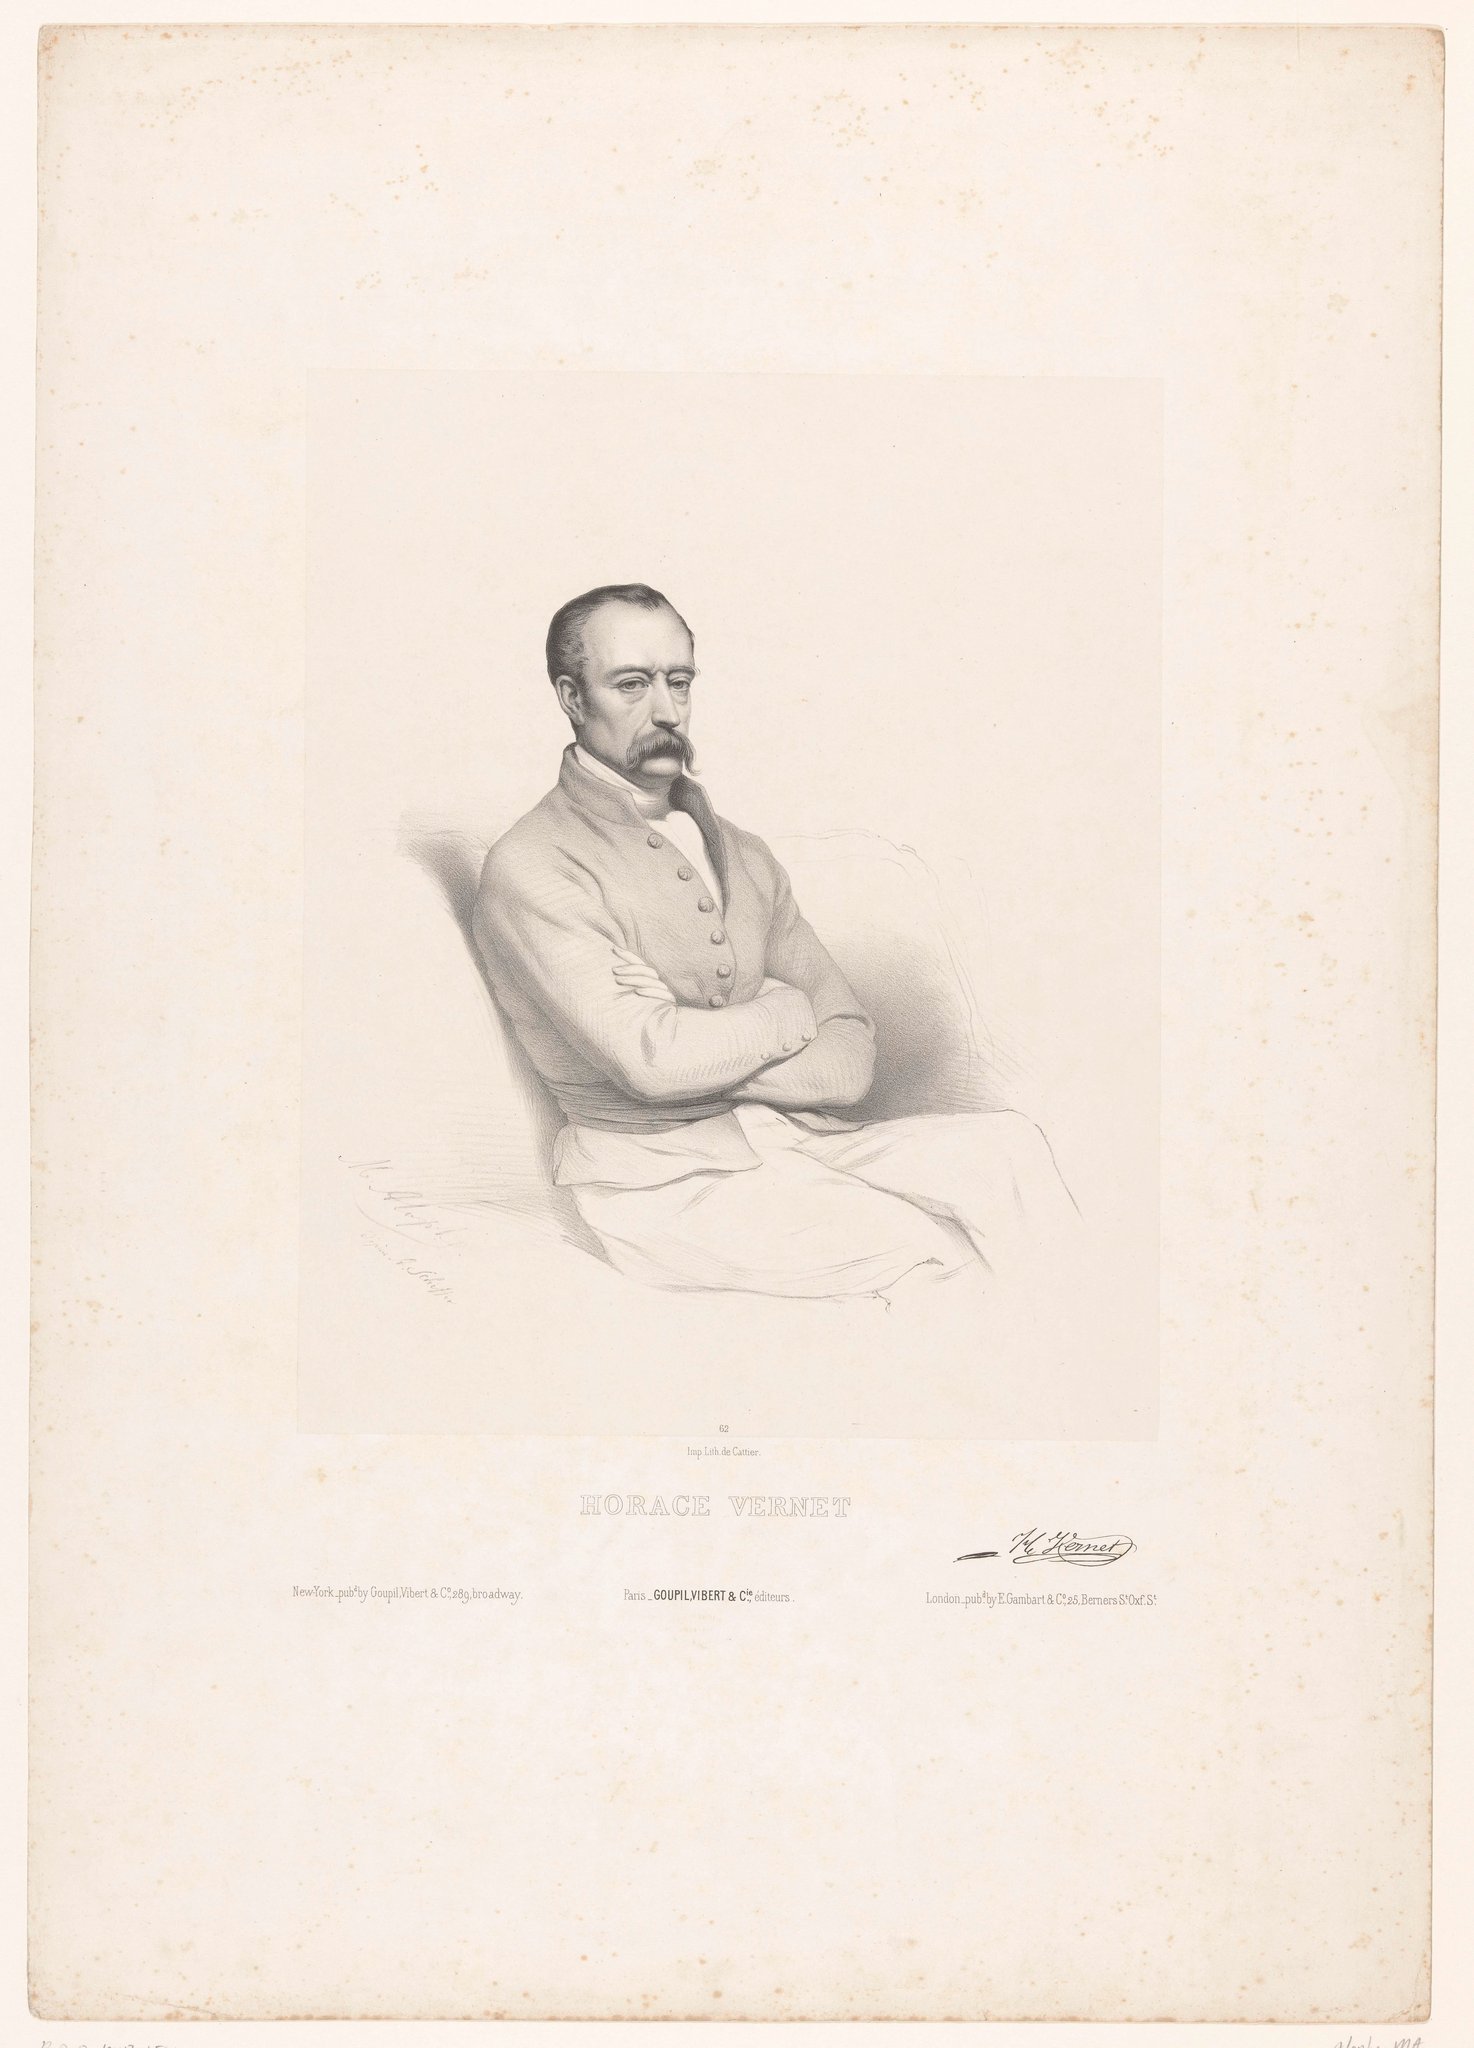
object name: print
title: Portret van de schilder Horace Vernet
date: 1859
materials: paper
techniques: lithography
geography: paris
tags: painter, print maker, draughtsman, horace vernet, historical persons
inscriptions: check stamp: Lugt 5004, collector's mark: Lugt 2228